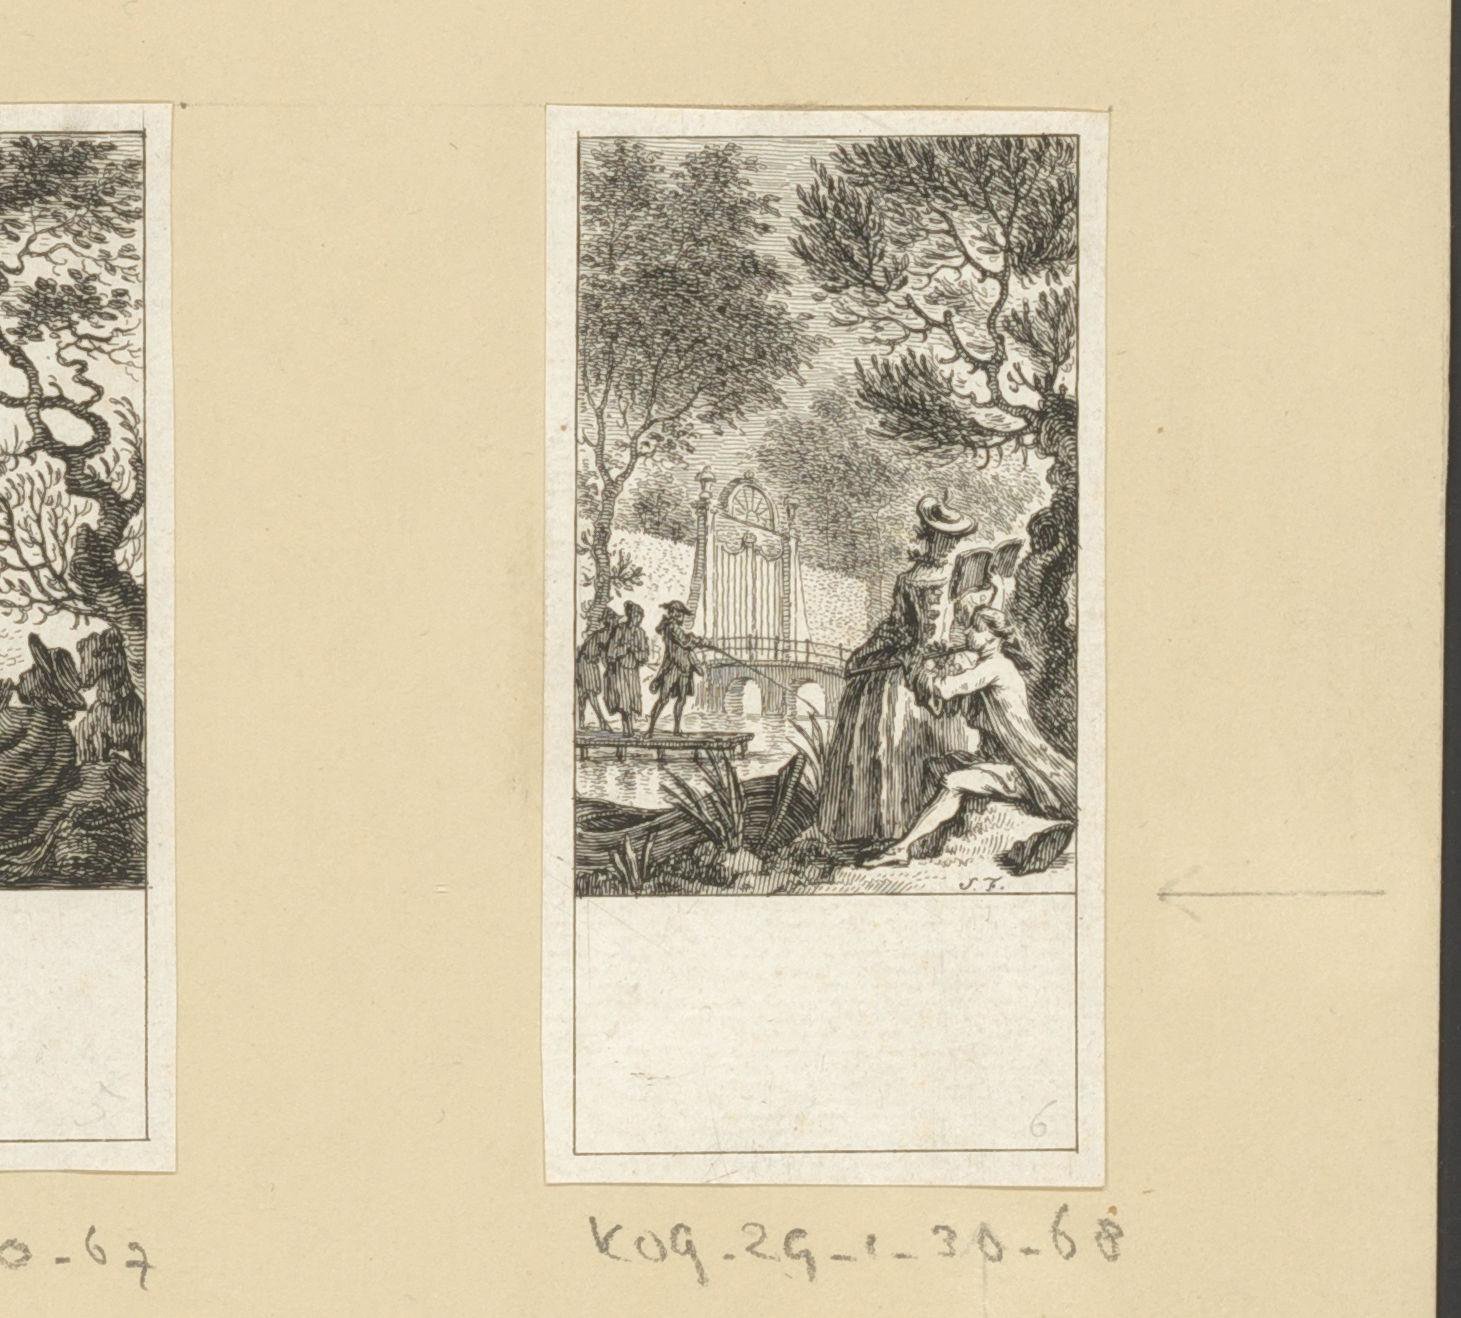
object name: print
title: Twaalf maanden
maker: simon fokke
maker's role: draughtsman, print maker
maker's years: 1712-1784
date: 1722-1784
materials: paper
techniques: etching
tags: may ~ other concepts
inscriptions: collector's mark: Lugt 1641, stamp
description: Uit een serie van twaalf prenten, de verbeelding van de maand mei. Op de oever bespeelt een heer een fluit en zingt een dame uit een liedboek mee. Verderop staan drie figuren op een steiger te vissen. Onderwerpsrubrieken binnen de Atlas Zeden en Gewoonten: Zeden en Gewoonten in engeren zin. Volksleven. Zinnebeeldige voorstellingen uit het volkleven op serieprenten. Maanden en diversen (allegorieën).